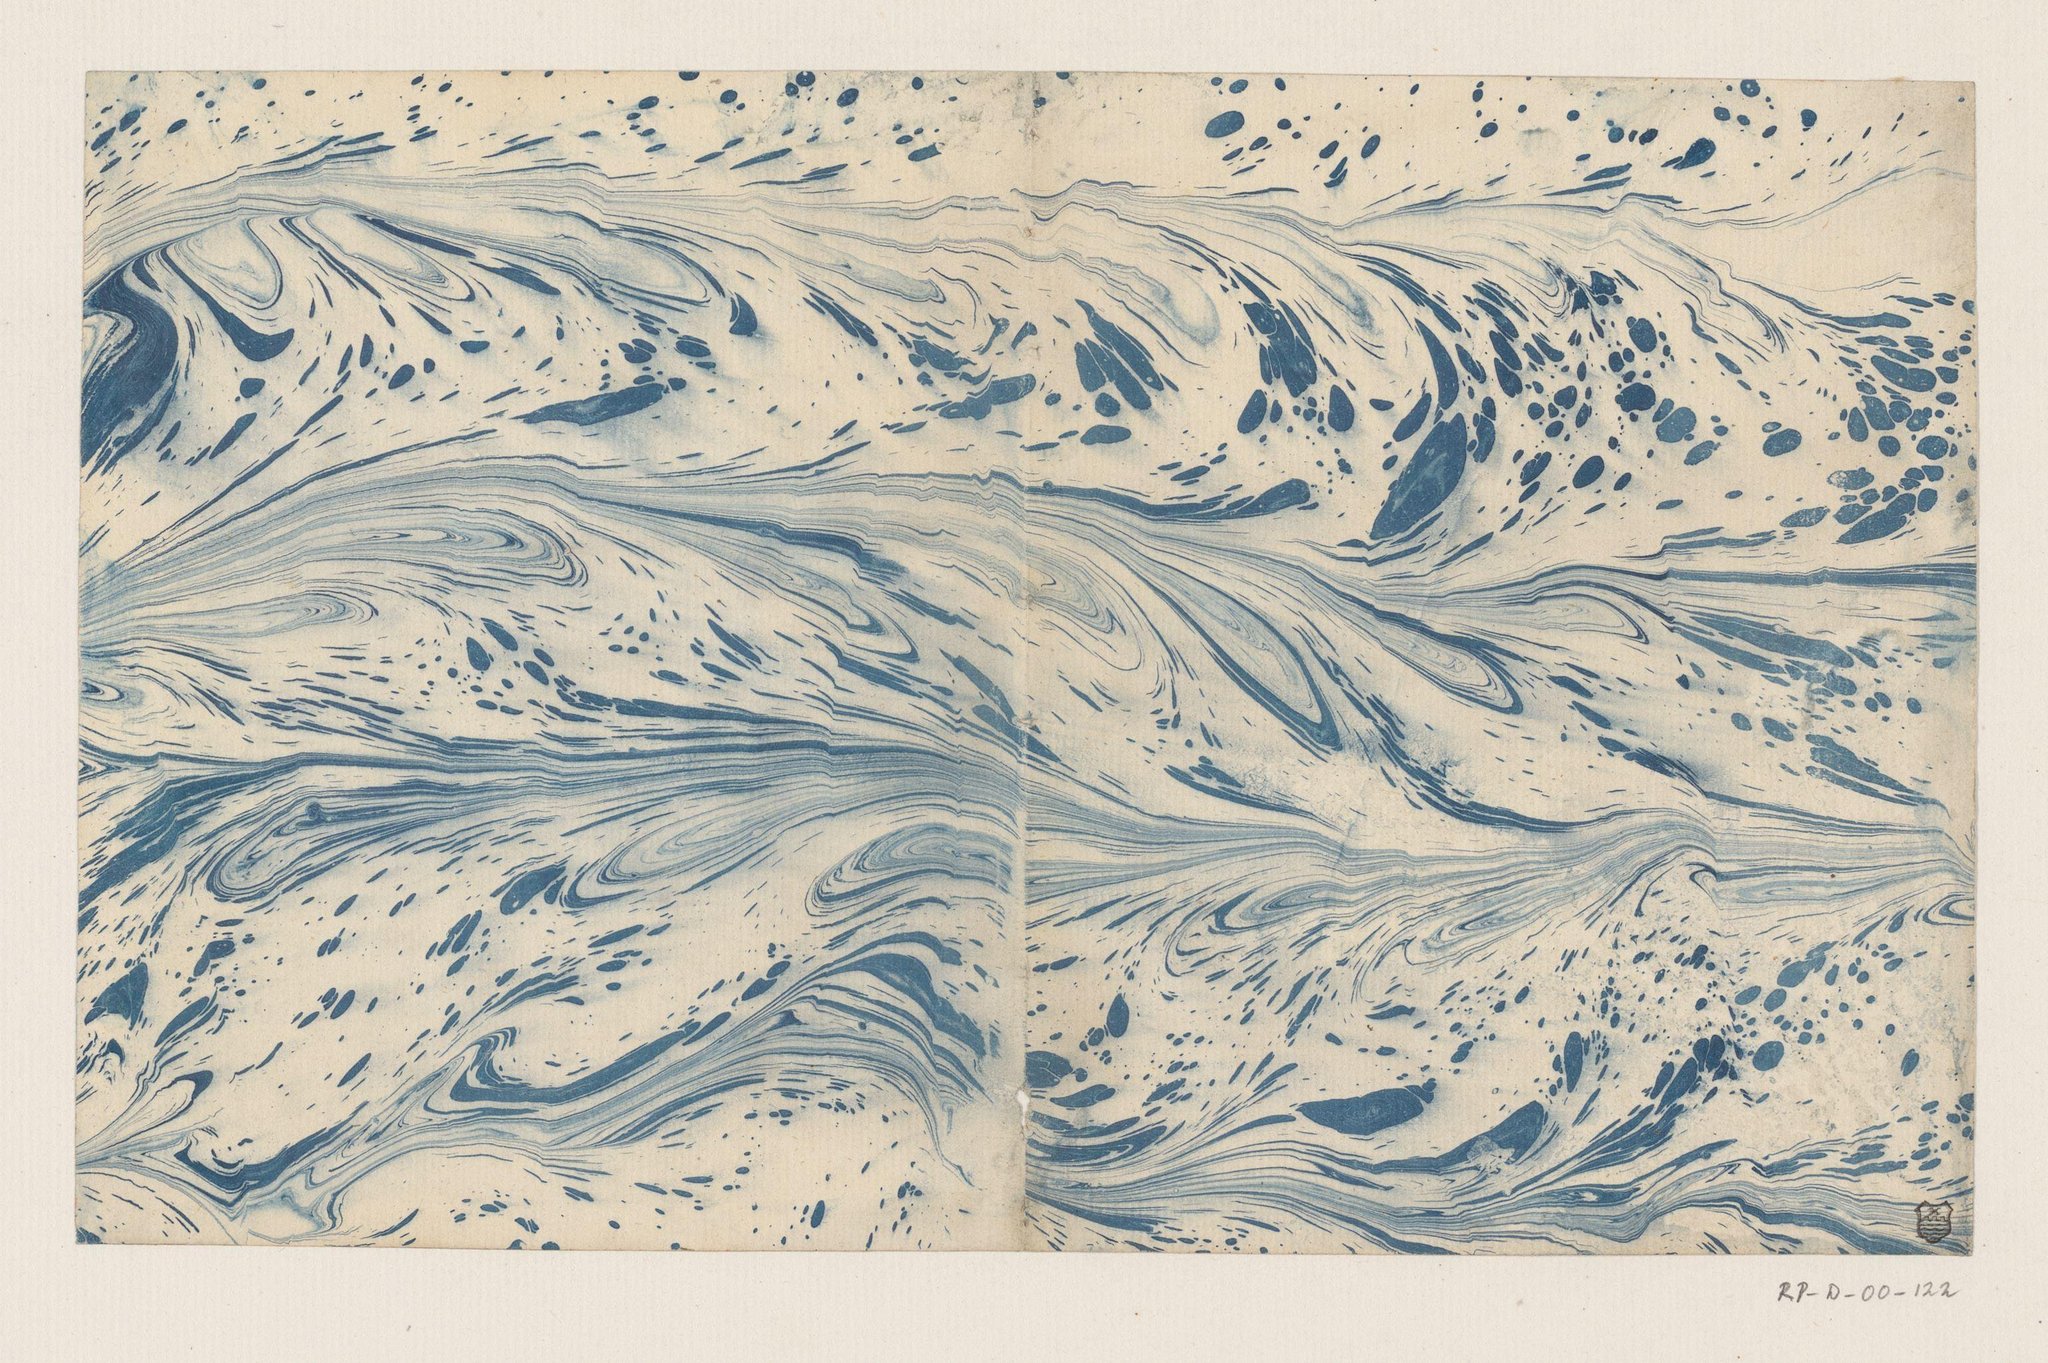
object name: wrapper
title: Fonteinmarmer in blauw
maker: Anonymous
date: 1700-1850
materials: paint, paper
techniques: marbling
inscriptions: collector's mark: Lugt 2760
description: Fonteinmarmer in blauw. Gebruikt als omslag.